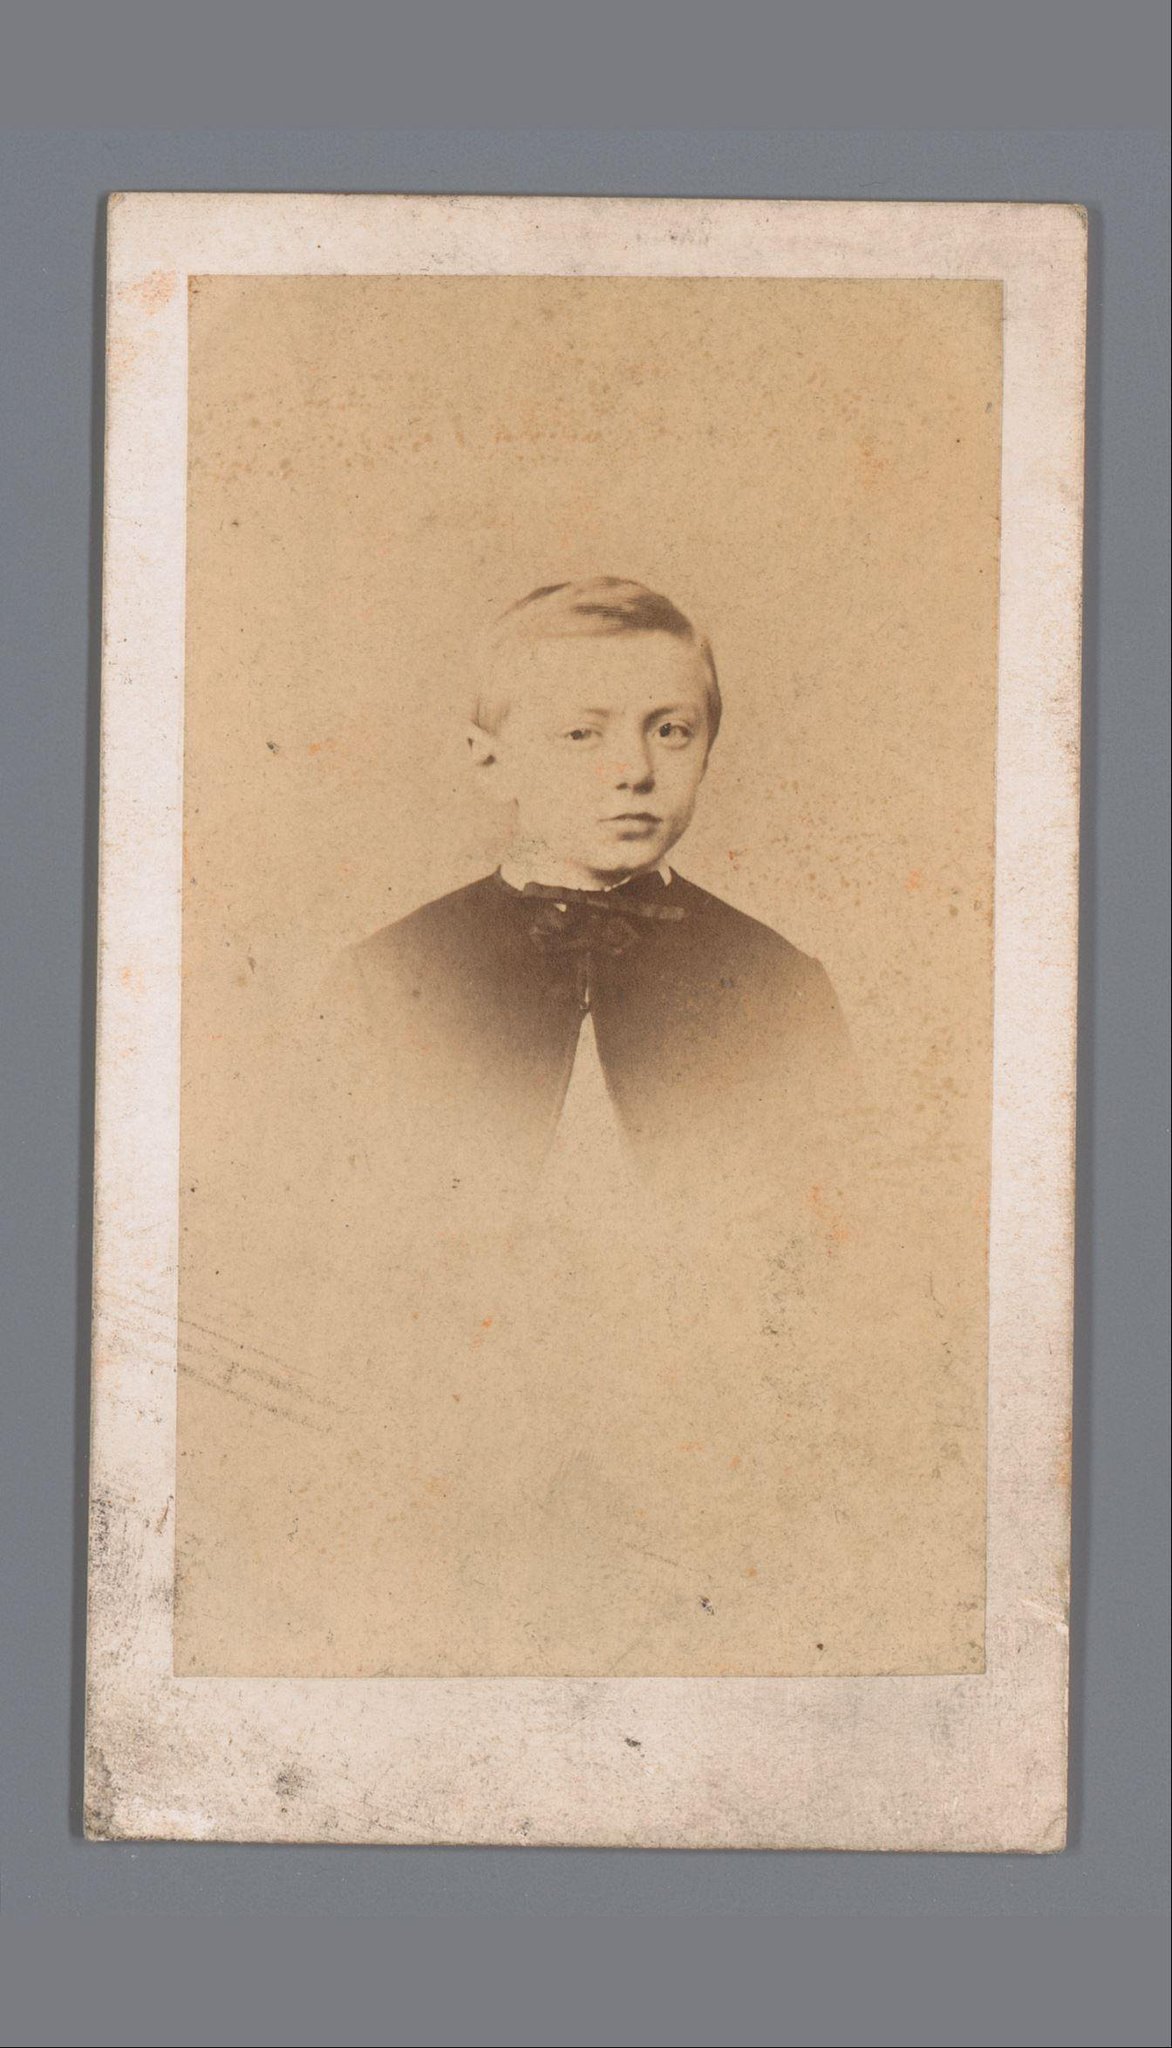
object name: photograph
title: Portret van een onbekende jongen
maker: raverdy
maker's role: fotograaf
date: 1855-1885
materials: cardboard, paper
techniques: albumen print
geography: valenciennes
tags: boy (child between toddler and youth), anonymous historical person portrayed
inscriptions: address: ‘23, Rue St. Géry, 23/ VALENCIENNES’, inscription: ‘Les Clichés sont conservés.’